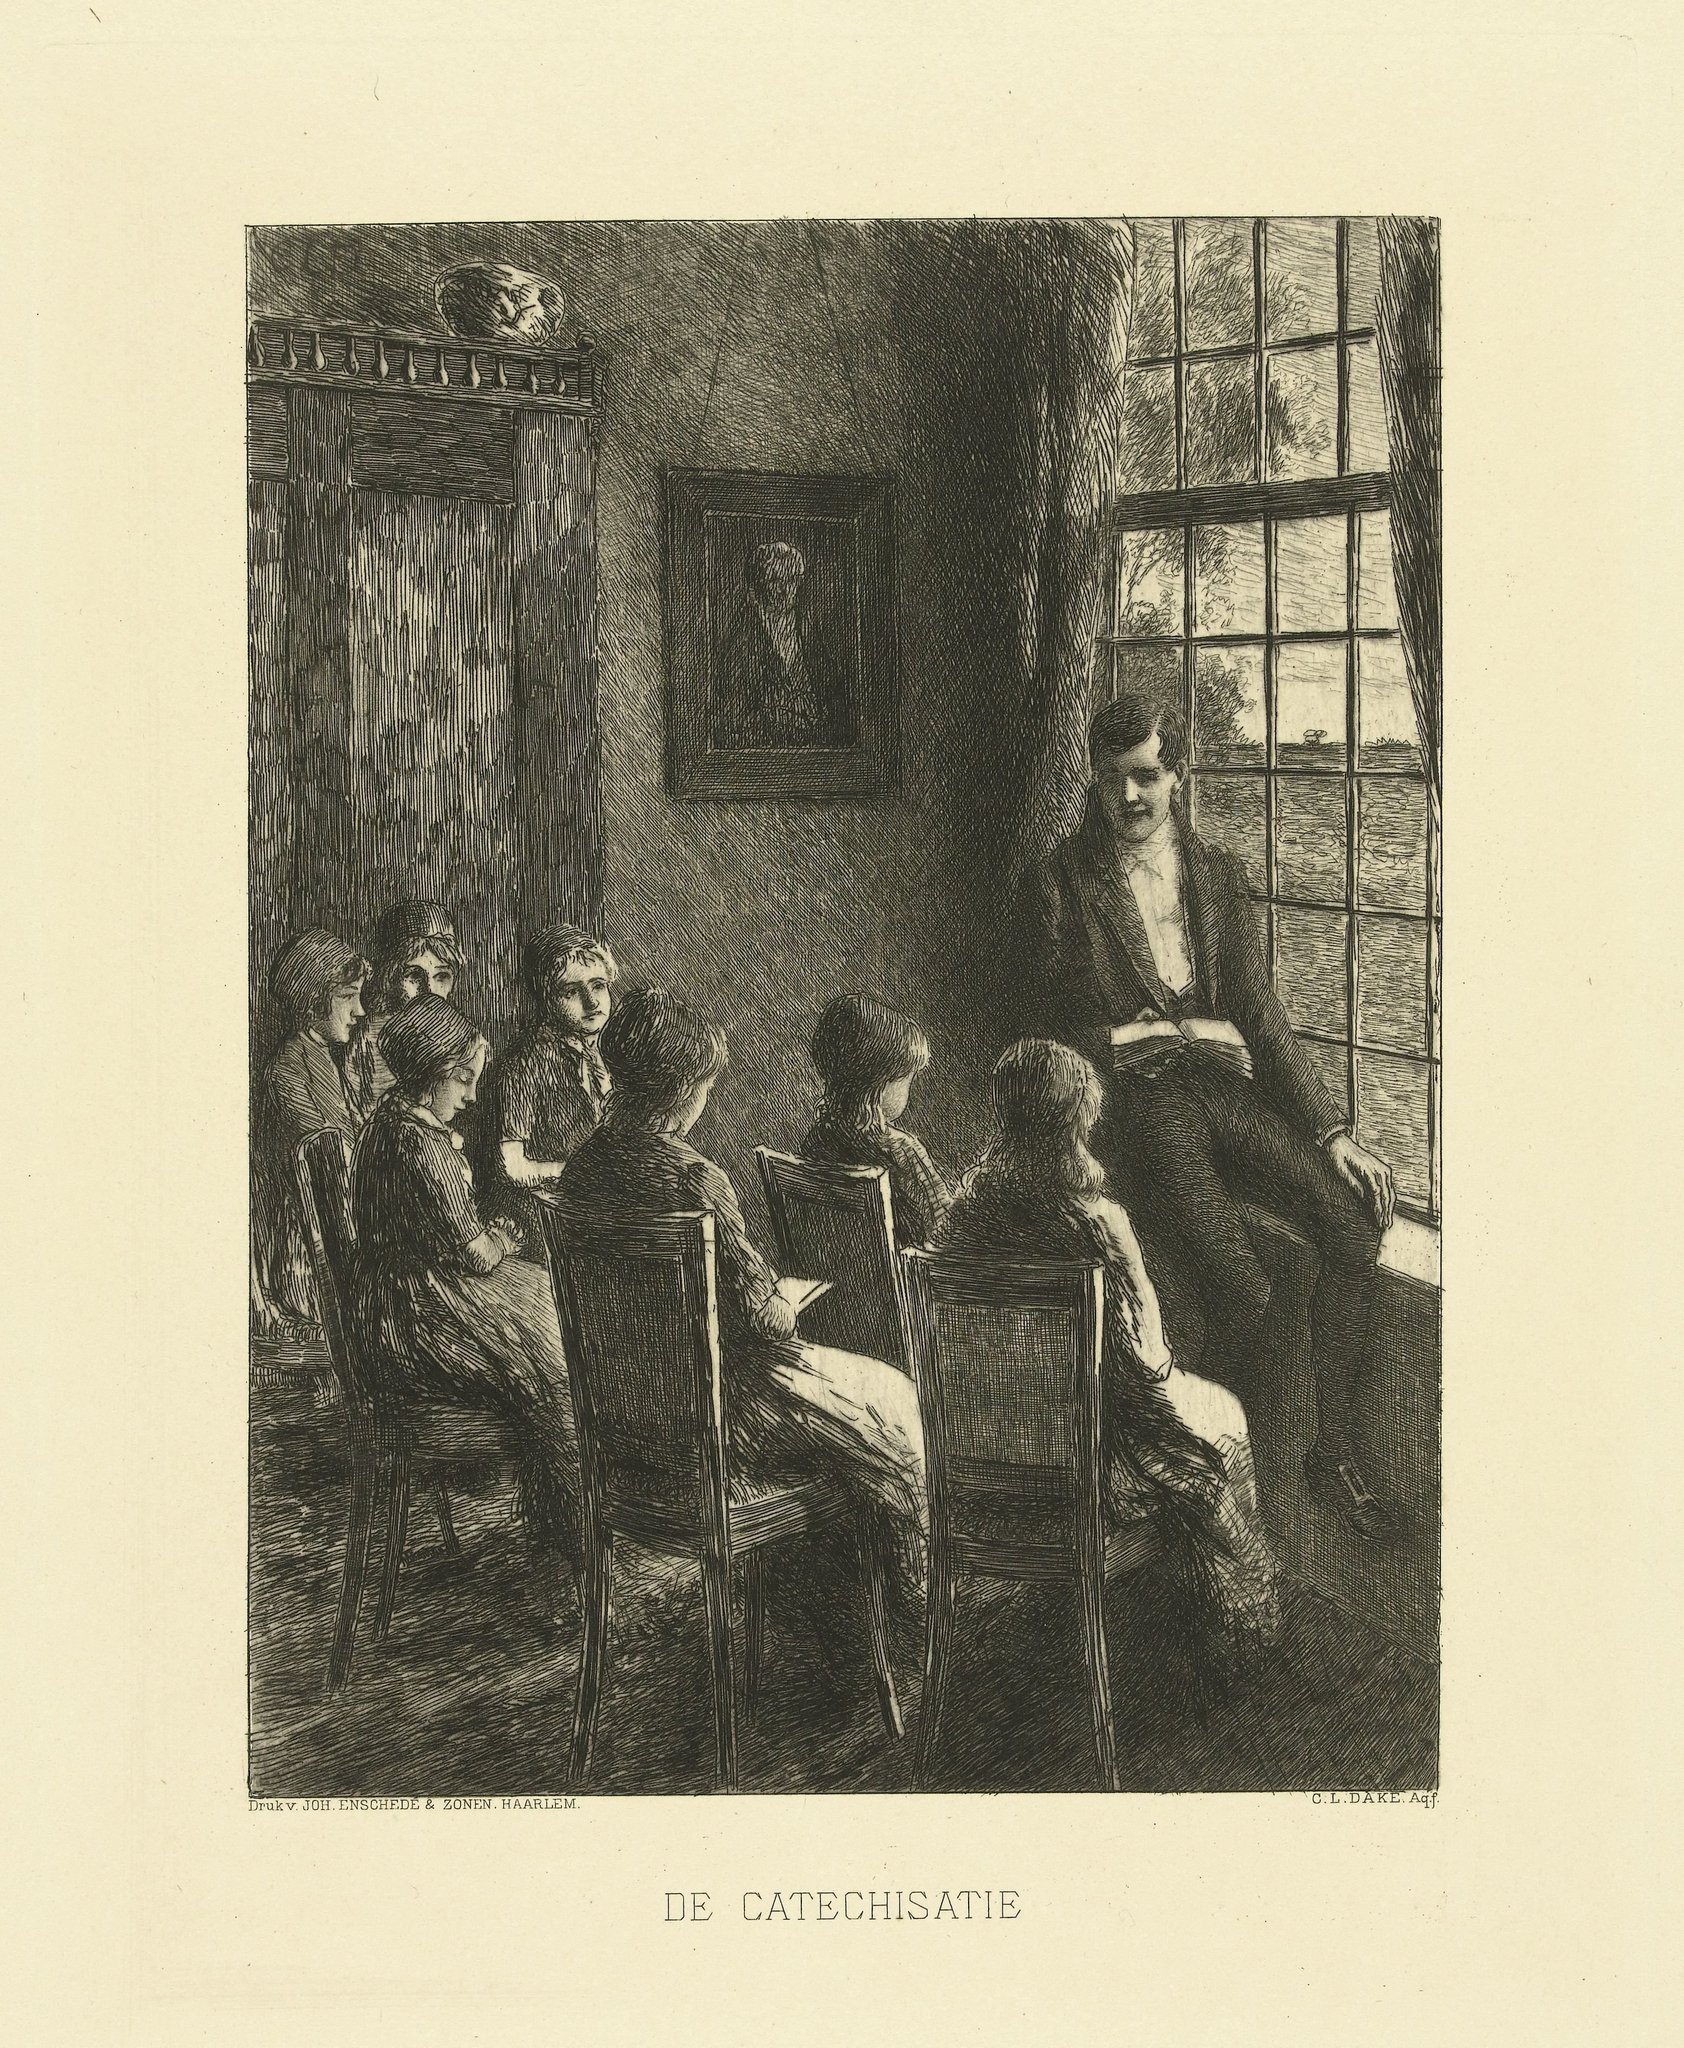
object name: print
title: De Catechisatie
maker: carel lodewijk dake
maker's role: draughtsman, painter, print maker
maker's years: 1857-1918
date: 1867-1904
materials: paper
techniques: etching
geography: haarlem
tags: teacher and pupil, reading the bible or other religious books, education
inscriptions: collector's mark: Lugt 2228